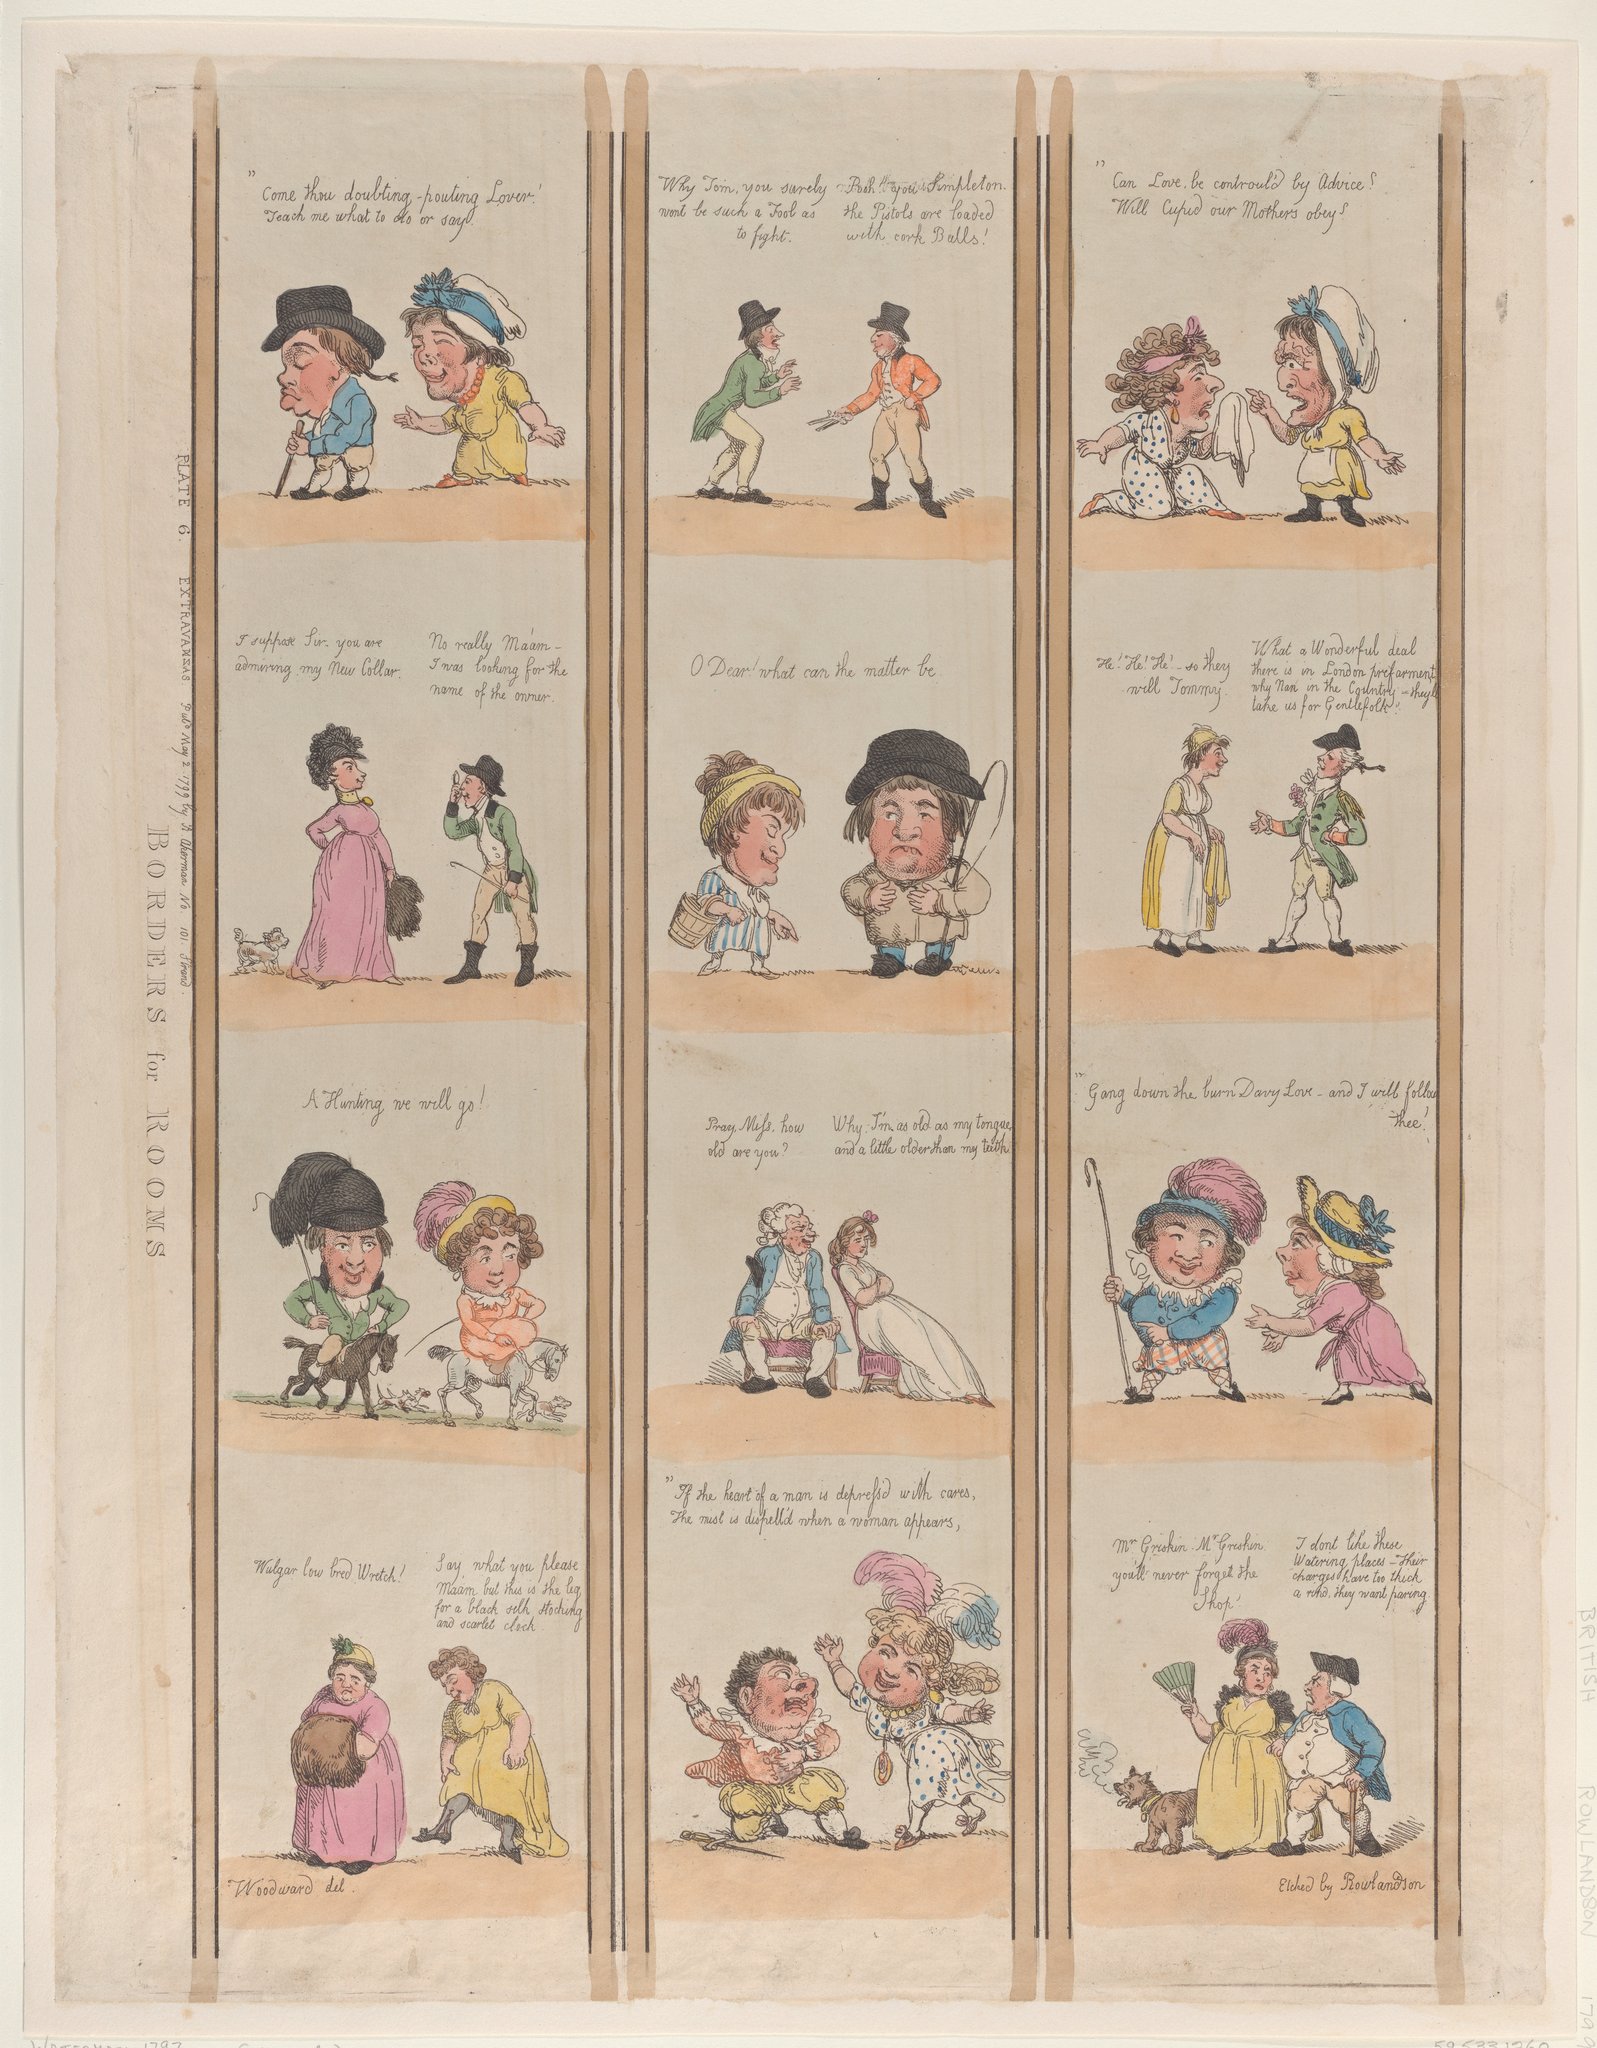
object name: print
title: Borders for Rooms, Extravaganzas Plate 6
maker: thomas rowlandson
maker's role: artist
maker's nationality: british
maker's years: 1757-1827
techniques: etching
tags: satire,men,women